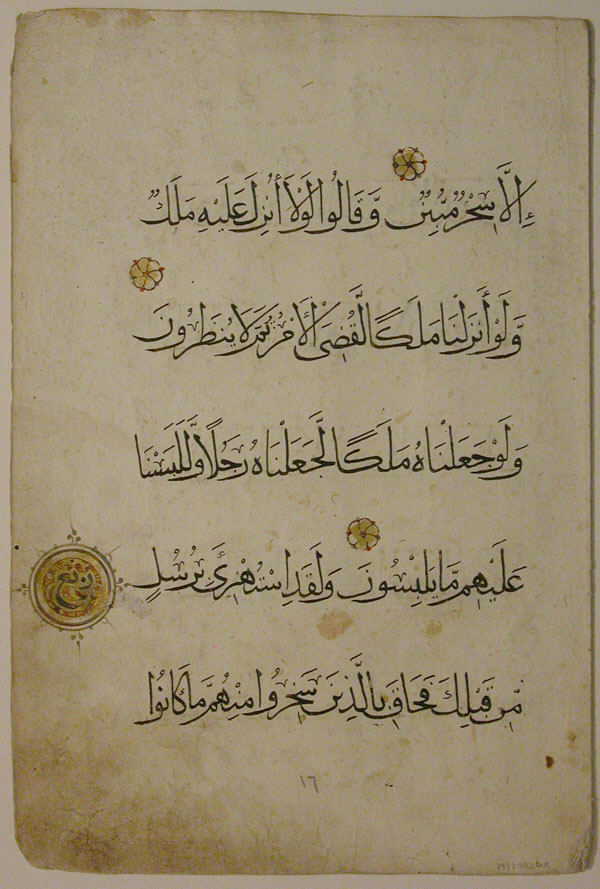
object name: folio from a non illustrated manuscript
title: Folios from a Qur'an Manuscript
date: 1301-1400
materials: gold, ink, paper, watercolor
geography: egypt or syria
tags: qur'an,calligraphy